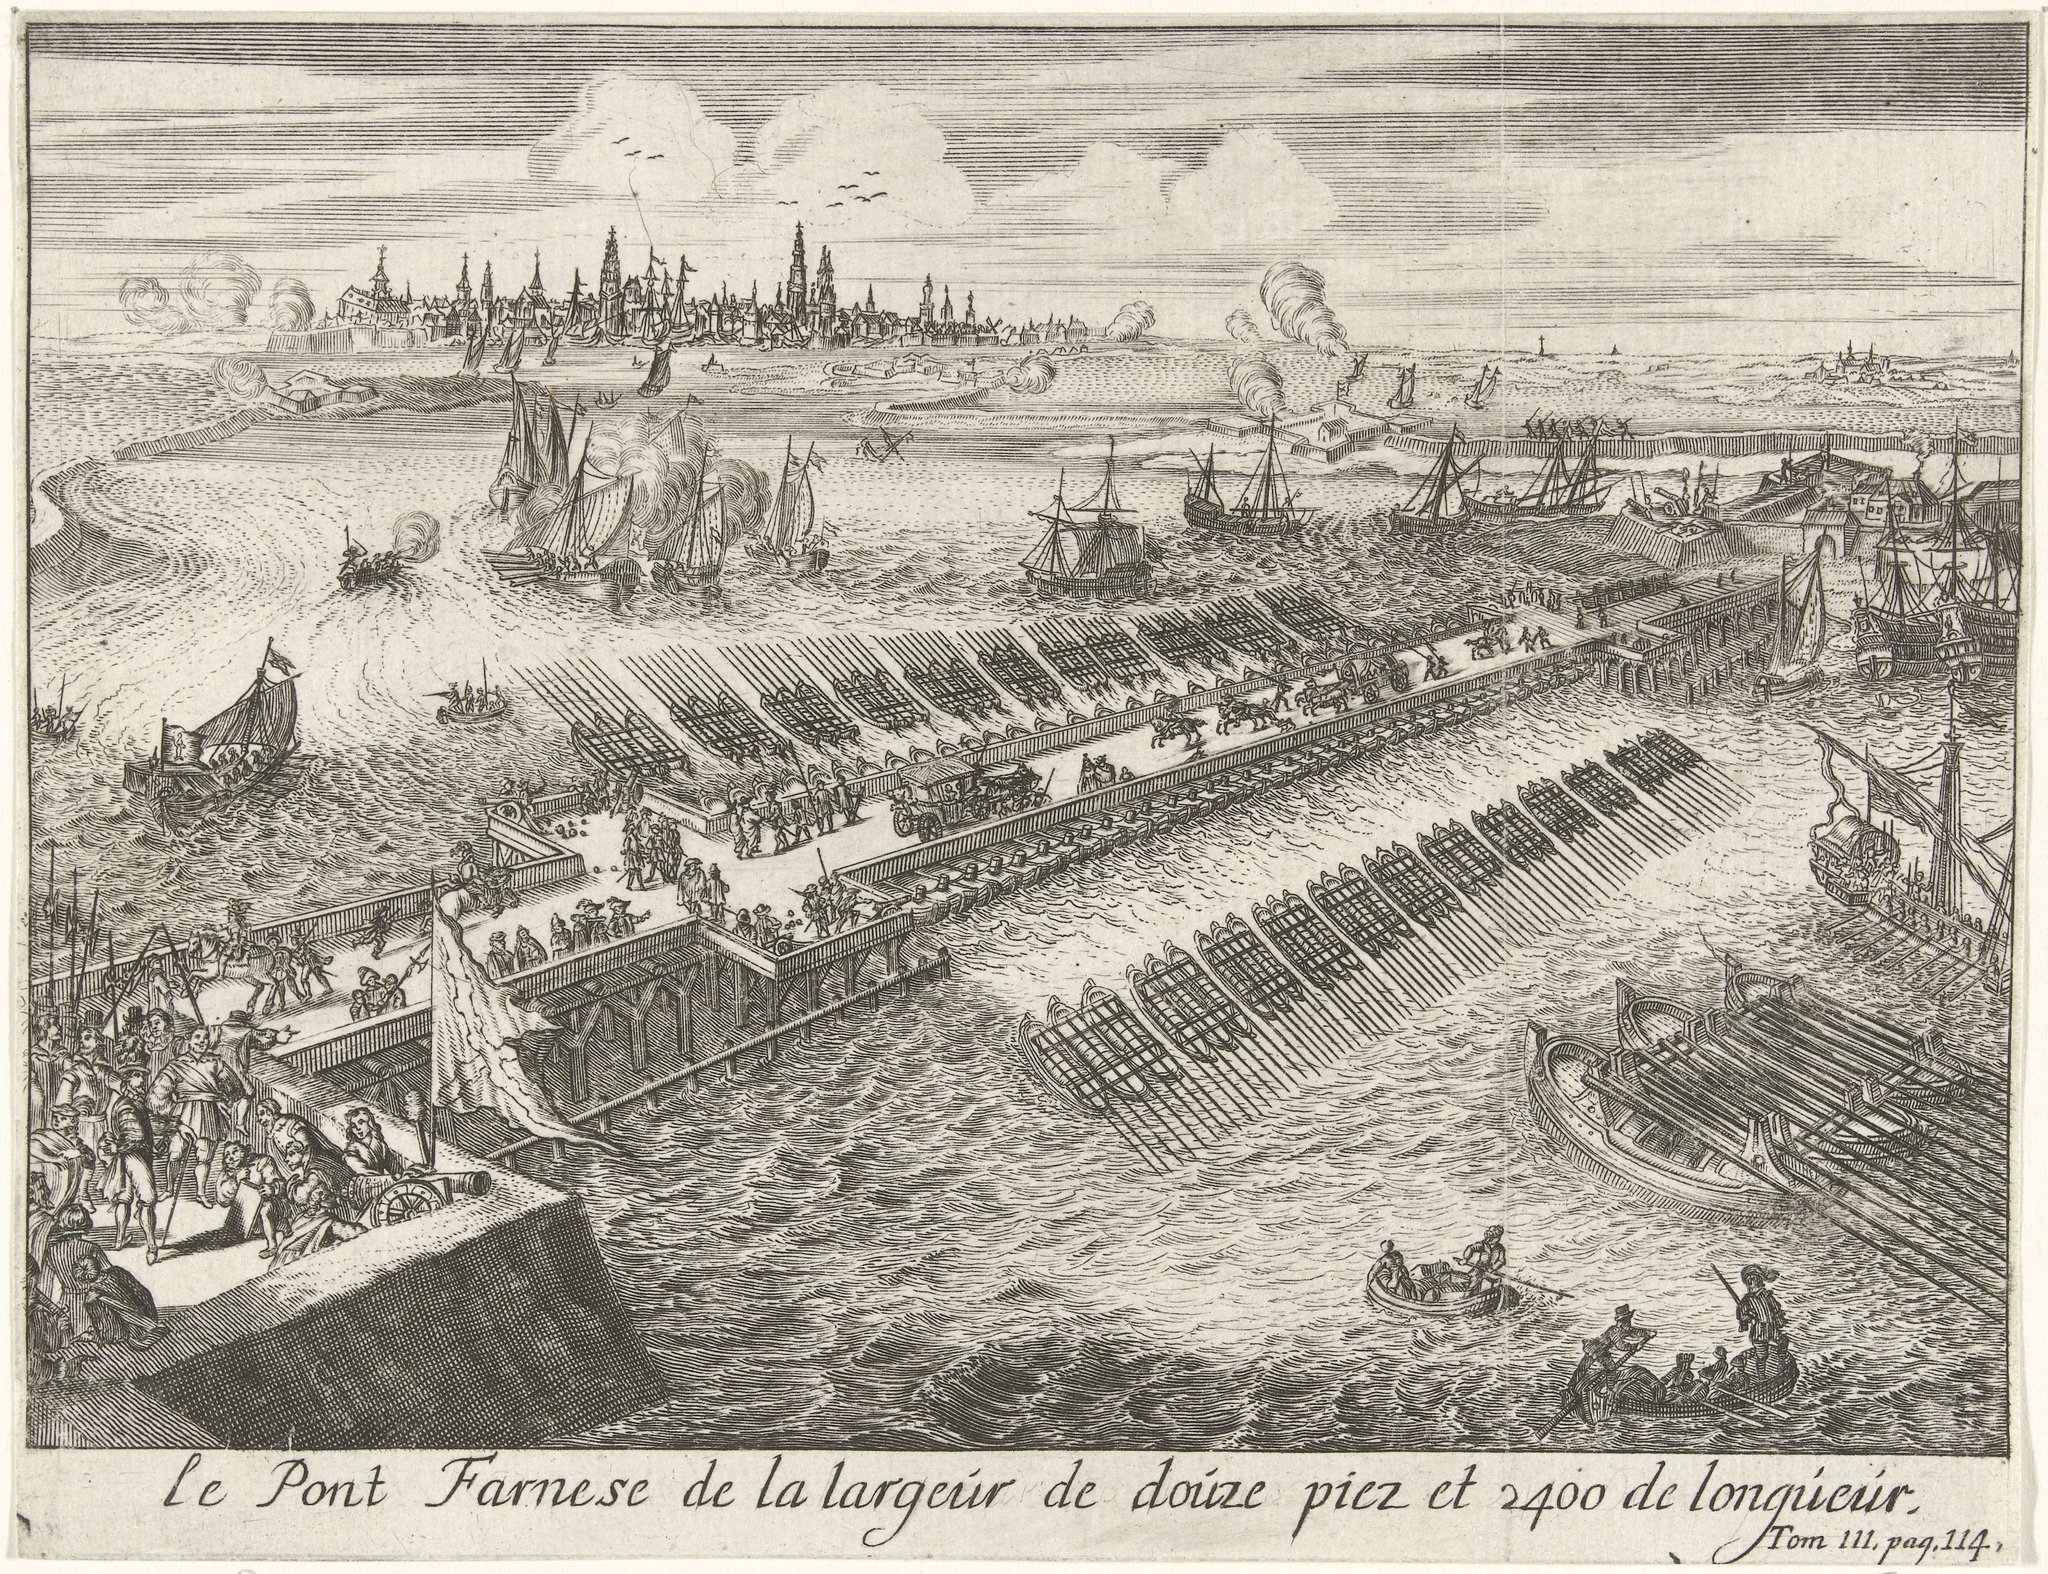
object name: print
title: Schipbrug van Parma over de Schelde, 1585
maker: lamberecht causé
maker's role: print maker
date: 1670-1699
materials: paper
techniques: engraving, etching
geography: low countries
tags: rome, alessandro farnese (landvoogd van de nederlanden en hertog van parma en piacenza), pontoon bridge, antwerp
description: De schipbrug aangelegd door de hertog van Parma over de Schelde, 1585. Linksvoor keurt Farnese het ontwerp voor de schipbrug goed. In de verte de stad Antwerpen. Rijtuigen en soldaten gaan over de voltooide brug.